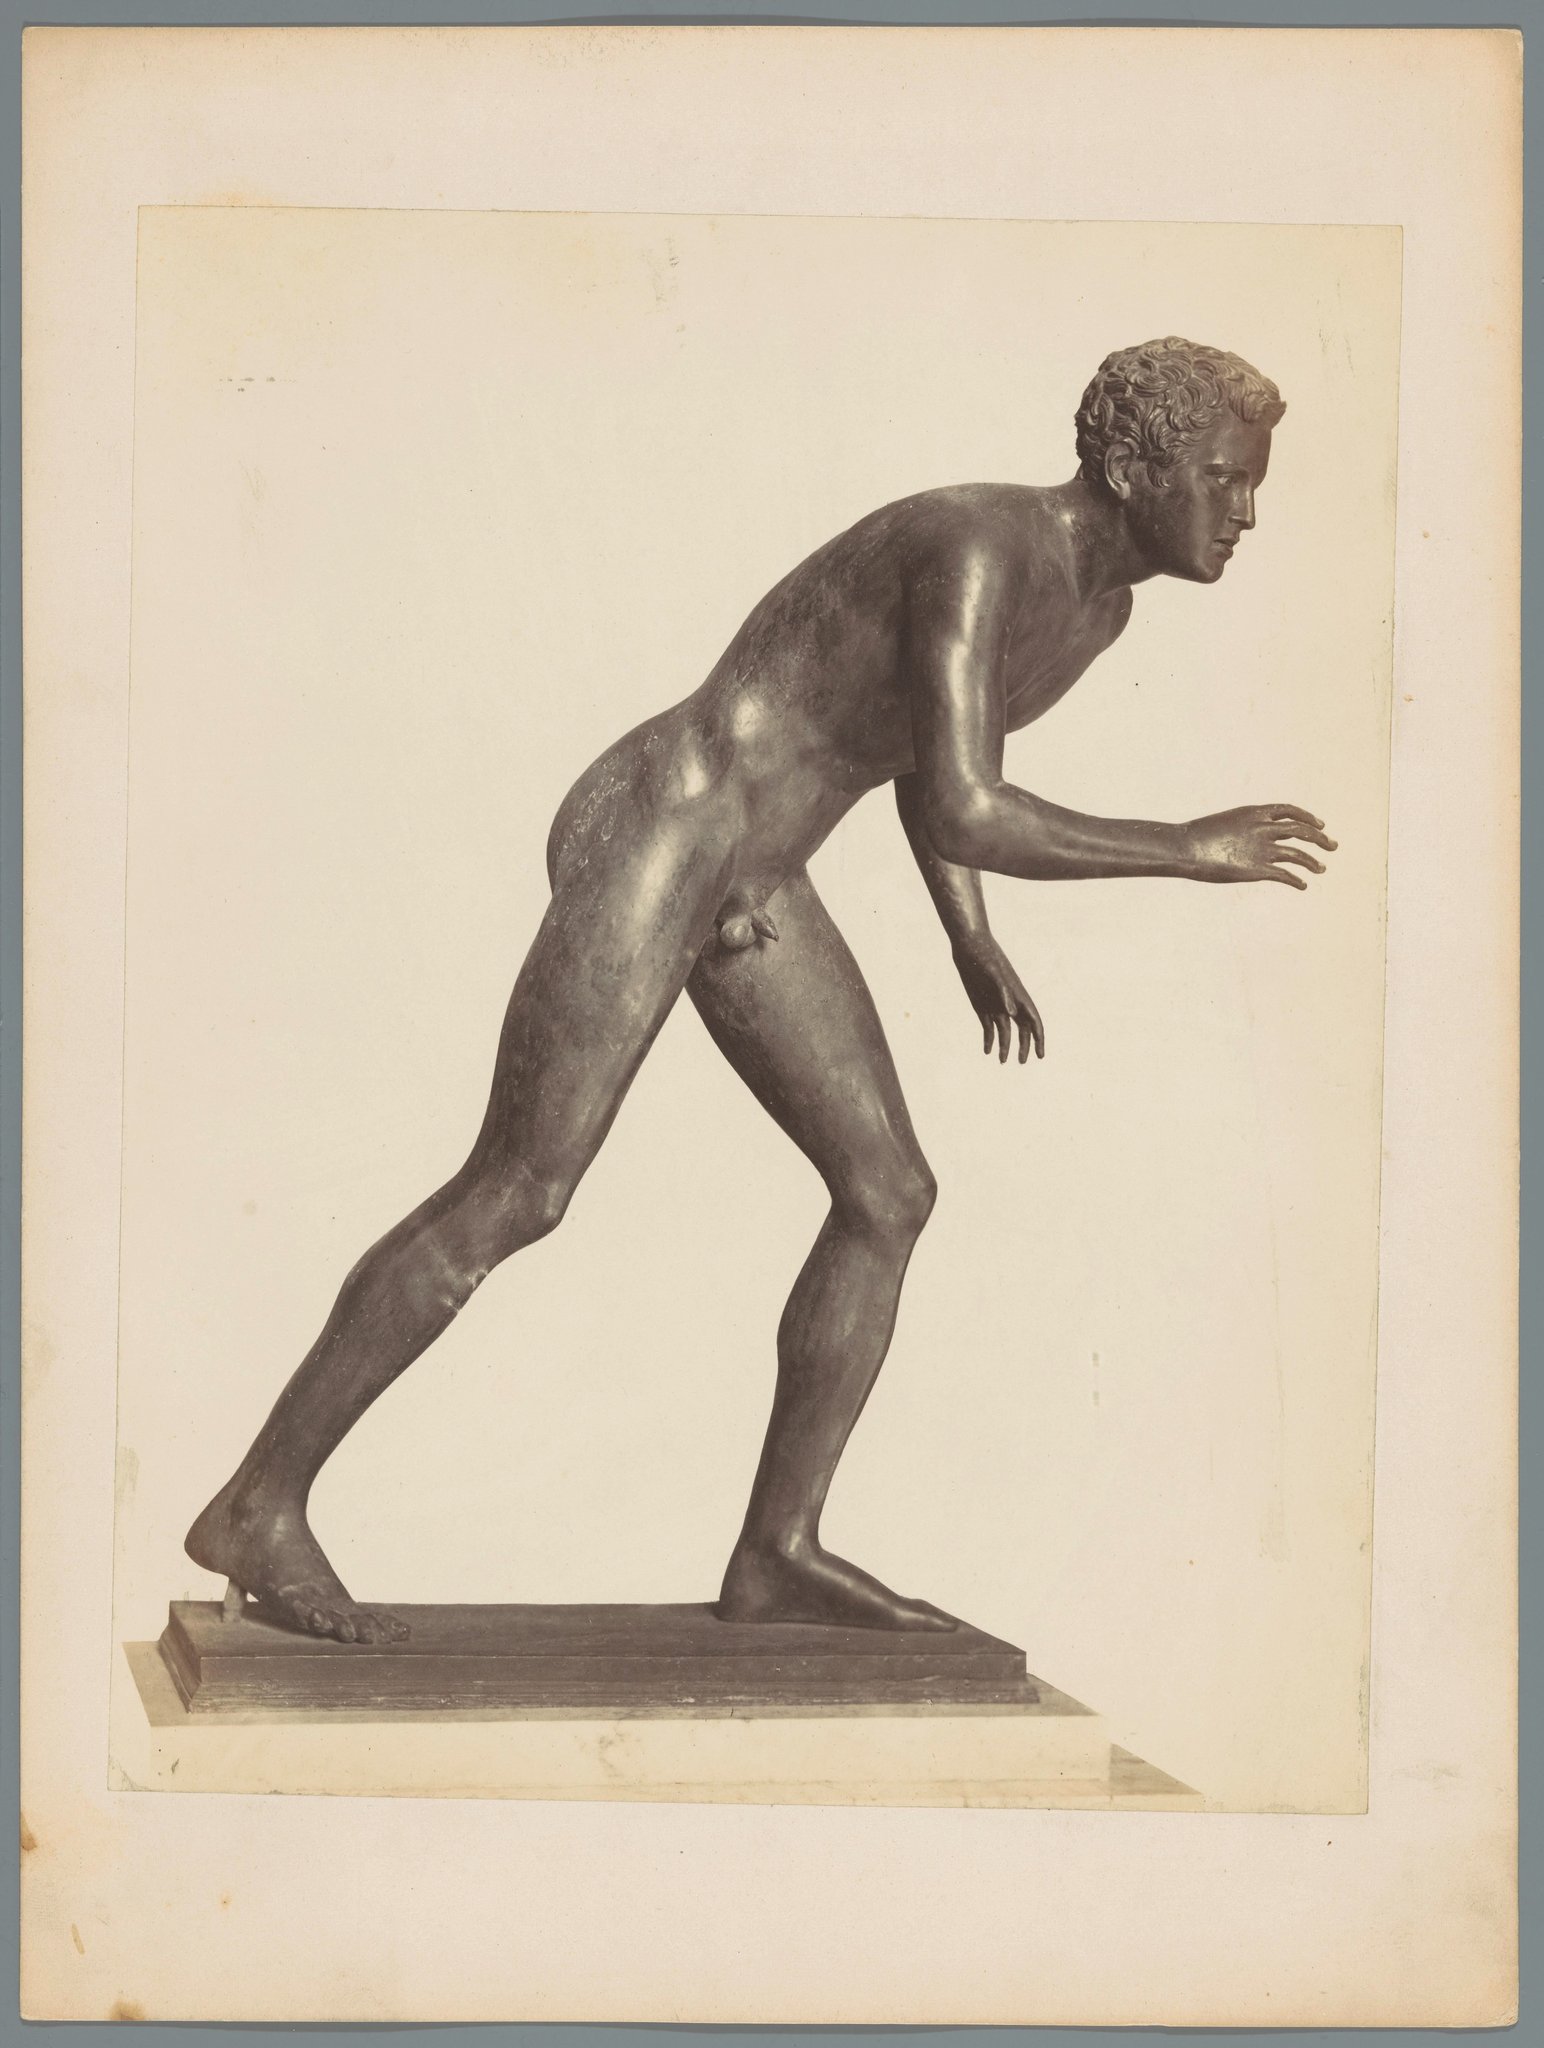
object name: photograph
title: Hardloper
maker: Anonymous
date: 1875-1900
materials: cardboard, photographic support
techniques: albumen print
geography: europe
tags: piece of sculpture, reproduction of a piece of sculpture (+ bronze ~ arts), man (showing himself) undressed, quasi-nude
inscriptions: collector's mark: Lugt 3937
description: Hardloper, gevonden in de Villa dei Papiri te Herculaneum.